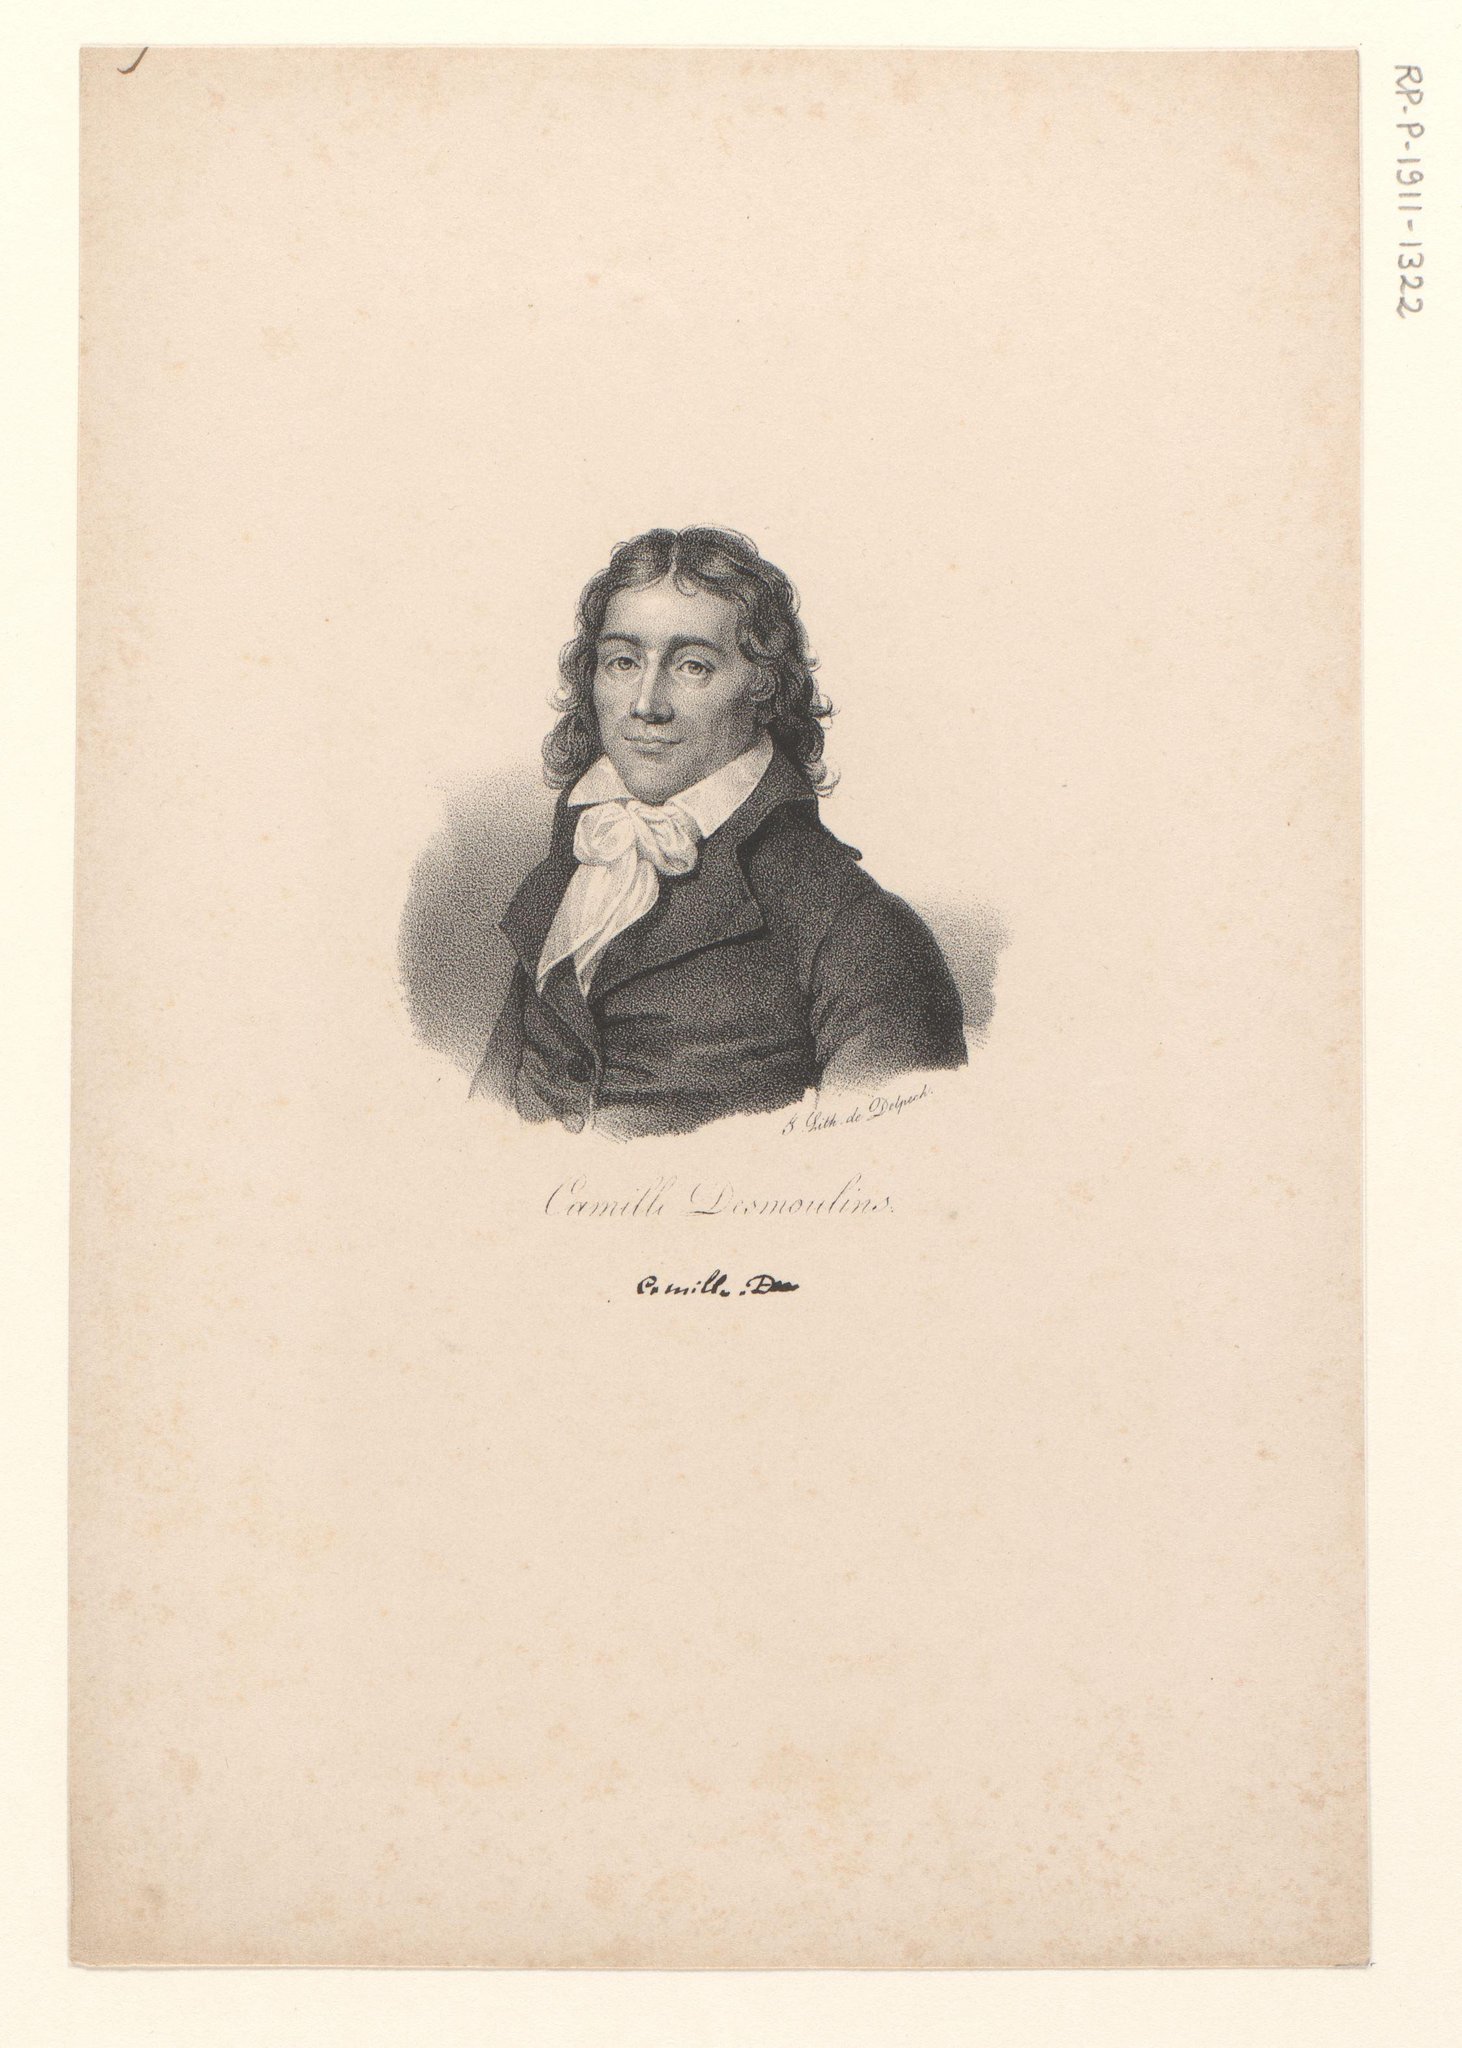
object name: print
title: Camille Desmoulins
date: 1818-1842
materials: paper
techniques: lithograph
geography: paris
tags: paris, politician, historical persons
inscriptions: collector's mark: Lugt 2228a